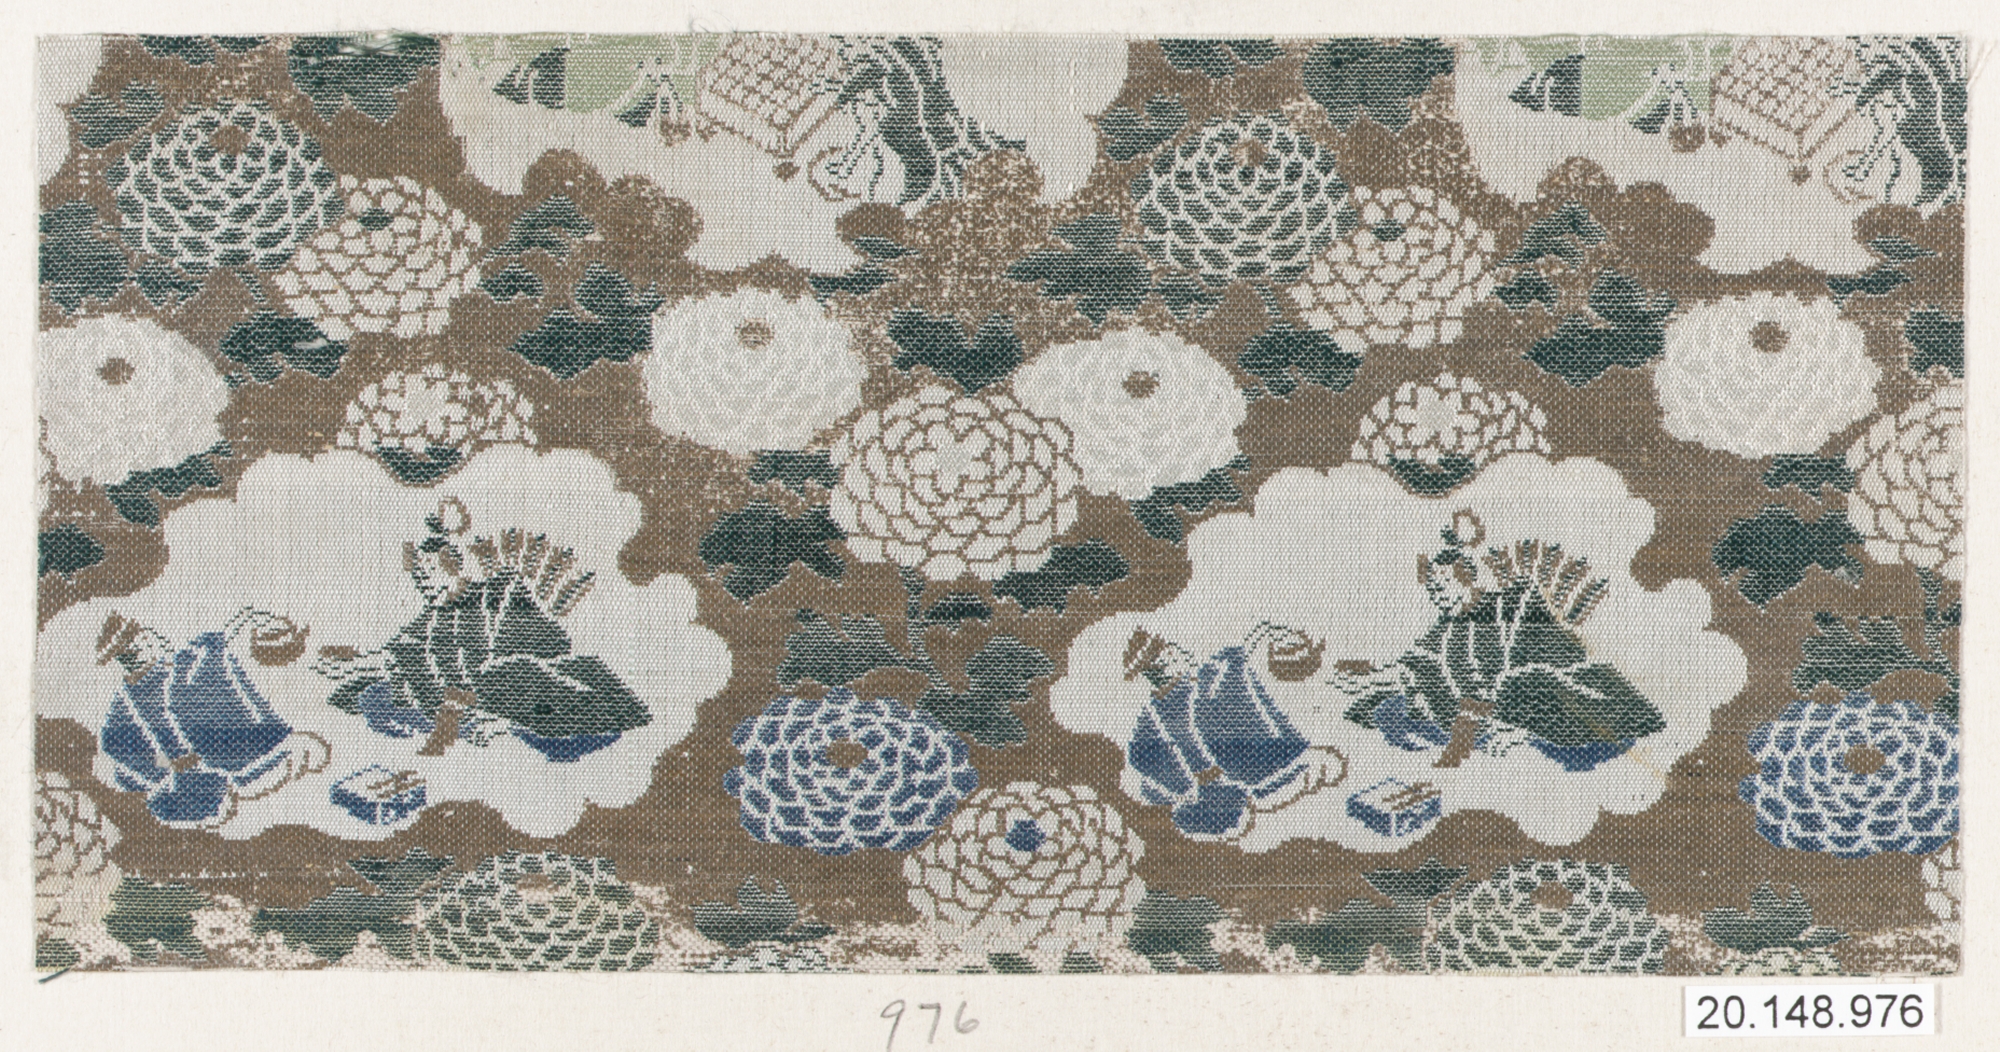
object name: piece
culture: japanese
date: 1701-1800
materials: silk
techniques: compound weave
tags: men,flowers